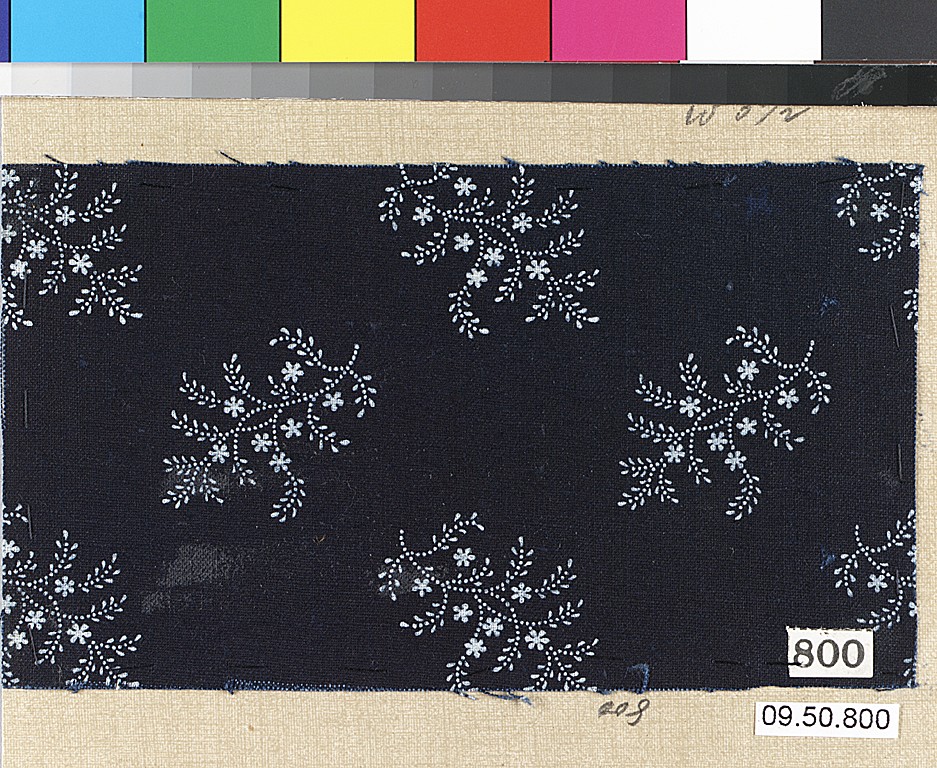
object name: piece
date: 1801-1900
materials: cotton